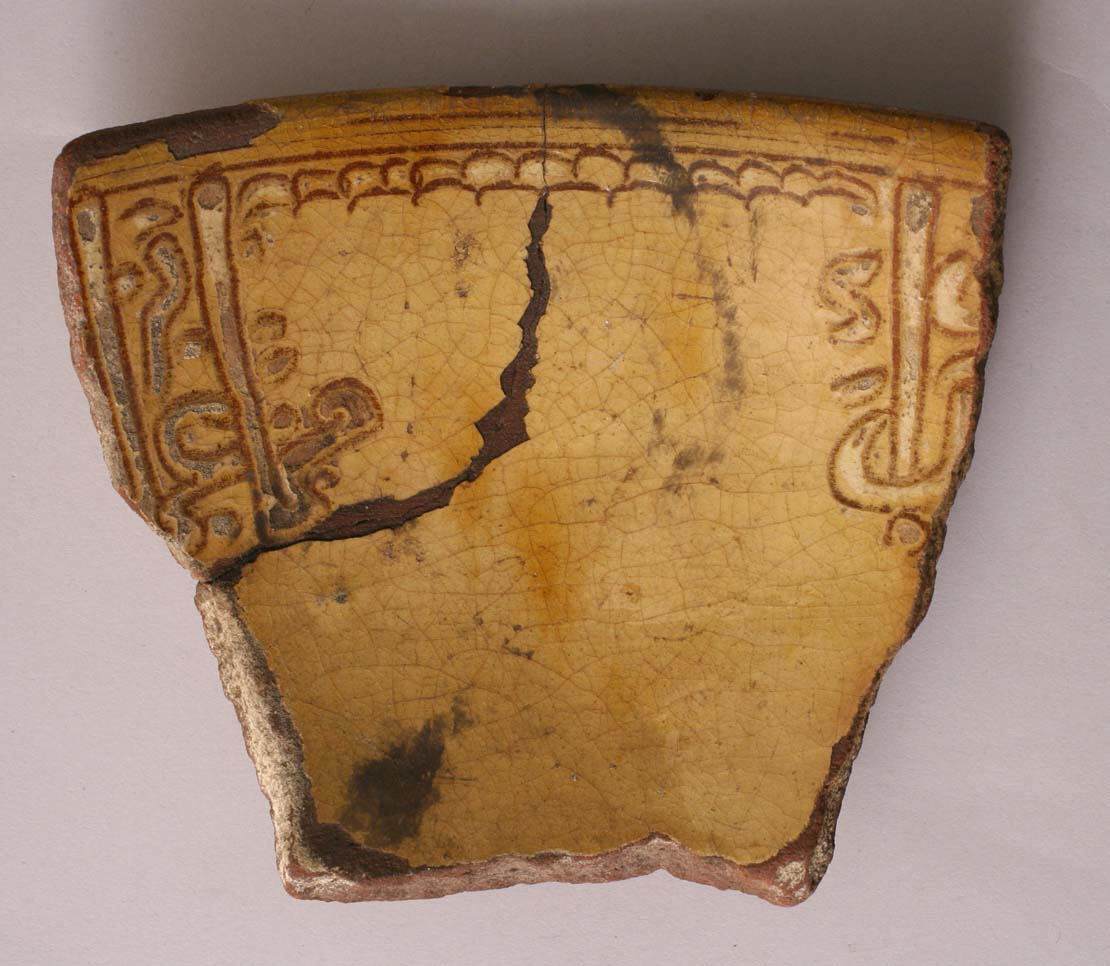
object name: fragment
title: Ceramic Fragment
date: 1301-1500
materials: earthenware, glaze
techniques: coloring, incising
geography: egypt